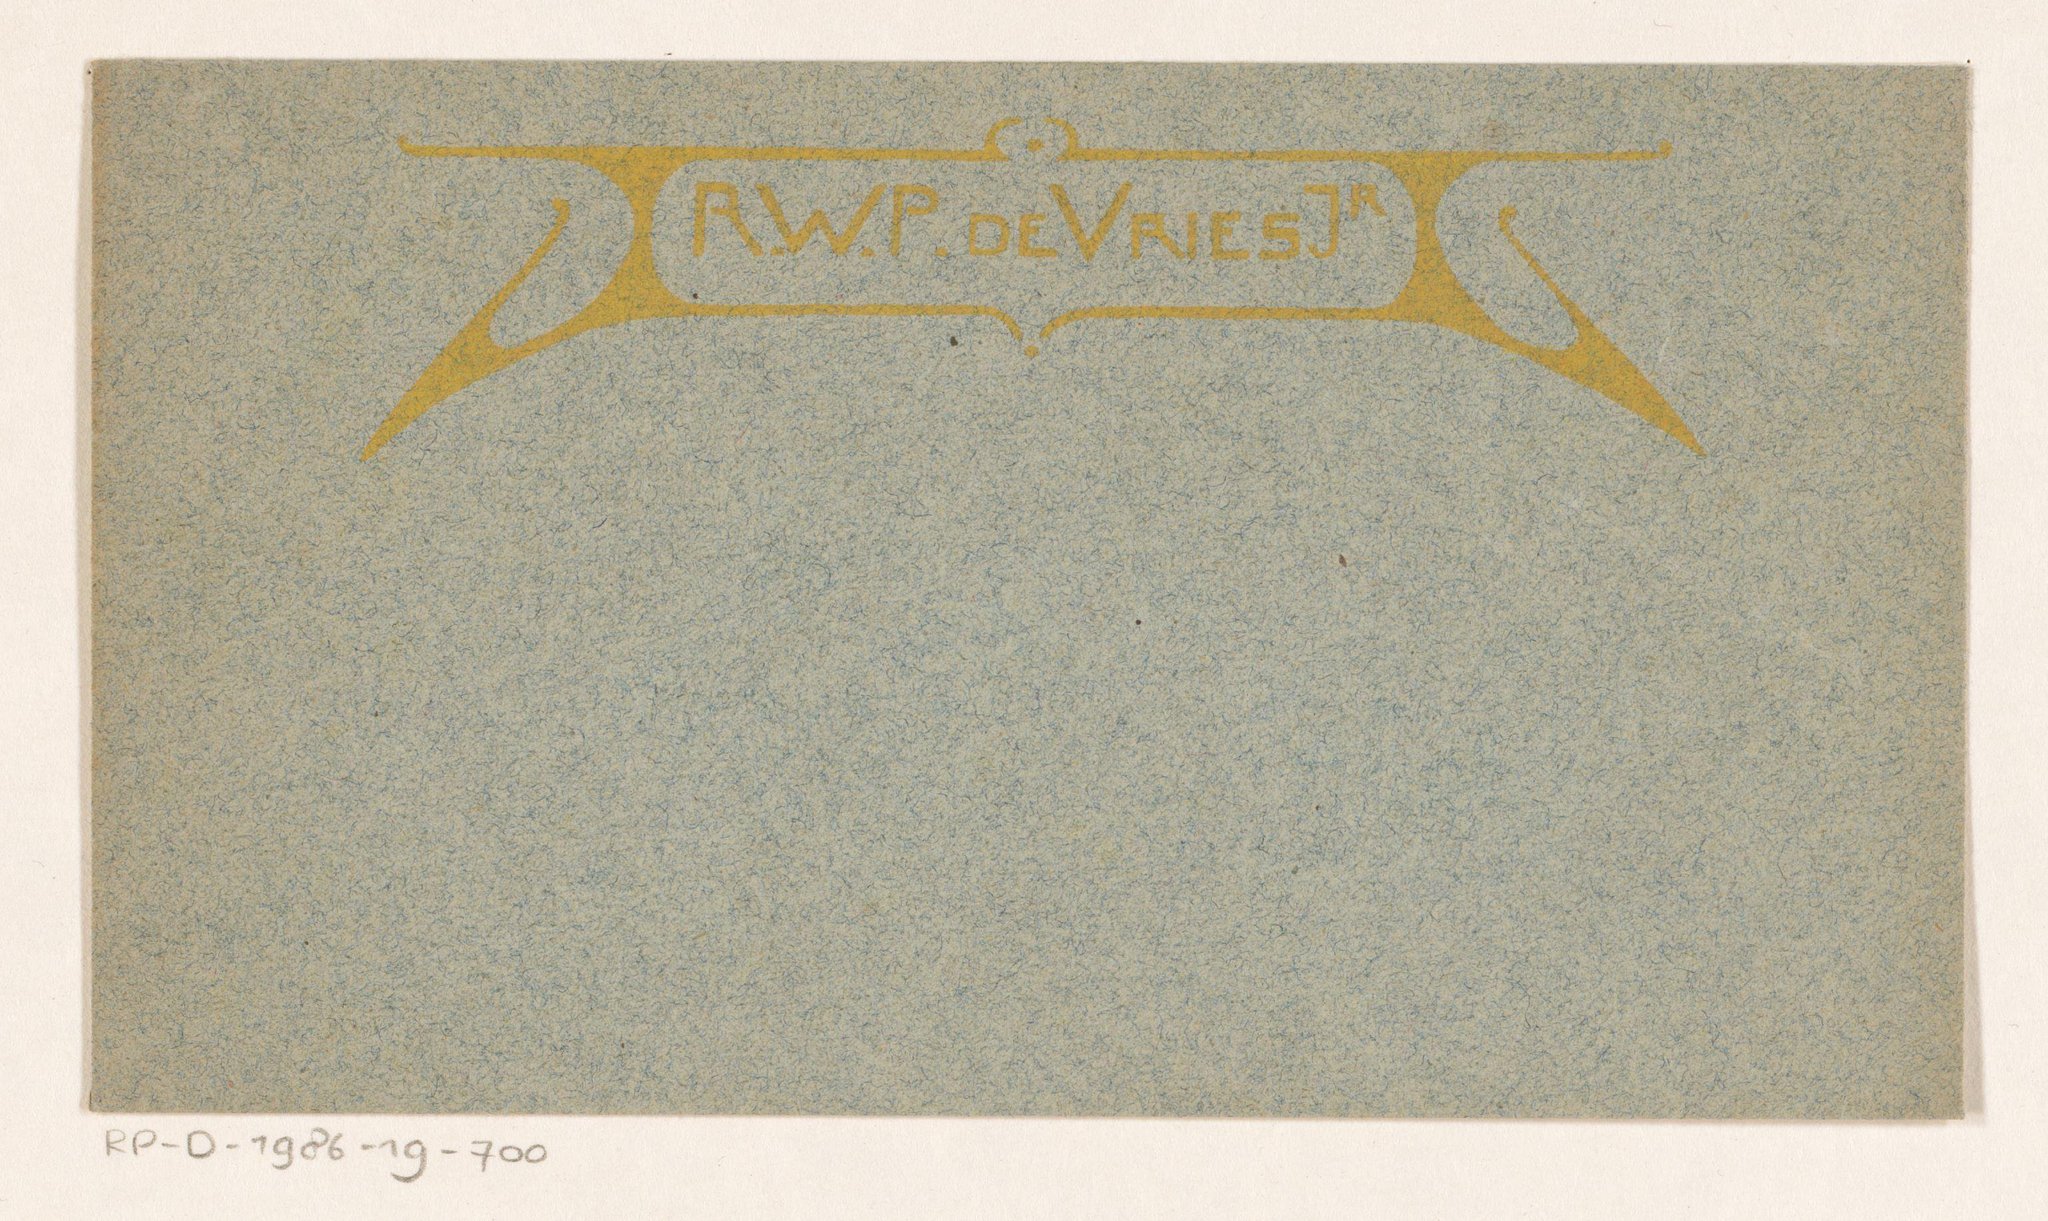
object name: envelope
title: Vignet R.W.P. de Vries Jr.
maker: reinier willem petrus de vries (1874-1953)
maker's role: draughtsman, print maker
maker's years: 1874-1953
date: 1884-1952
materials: paper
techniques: relief print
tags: amsterdam, print maker, draughtsman, reinier willem petrus de vries (1874-1953)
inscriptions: collector's mark: ‘R:MVS.’